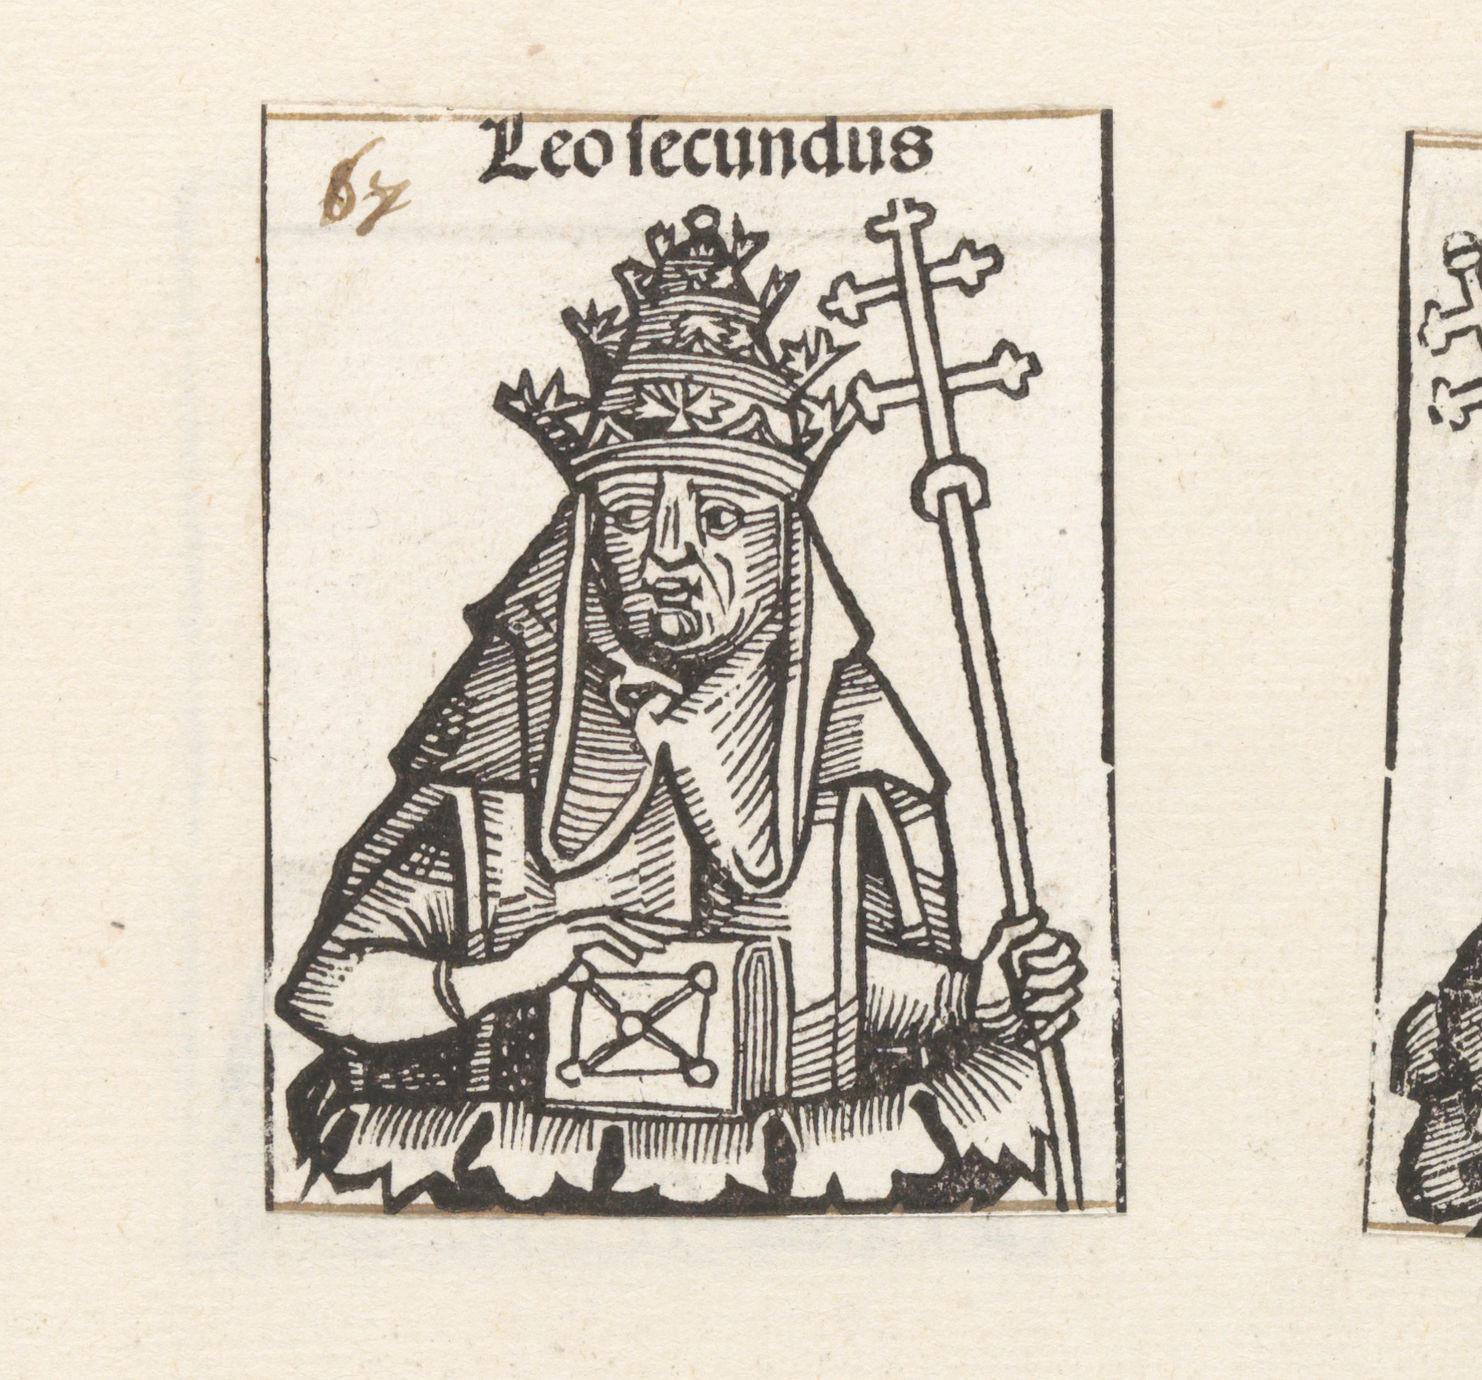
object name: album leaf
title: Paus Leo II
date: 1493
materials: paper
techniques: letterpress printing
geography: nuremberg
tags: rome, pope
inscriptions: inscription: ‘67’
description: Een bloemkelk met een paus. Hij draagt een tiara en heeft een bijbel en een staf met een dubbel kruis in zijn handen. De voorstelling is onderdeel van de opeenvolging pausen in de Liber Chronicarum. De tekst identificeert de man als Leo II. De prent maakt deel uit van een album.